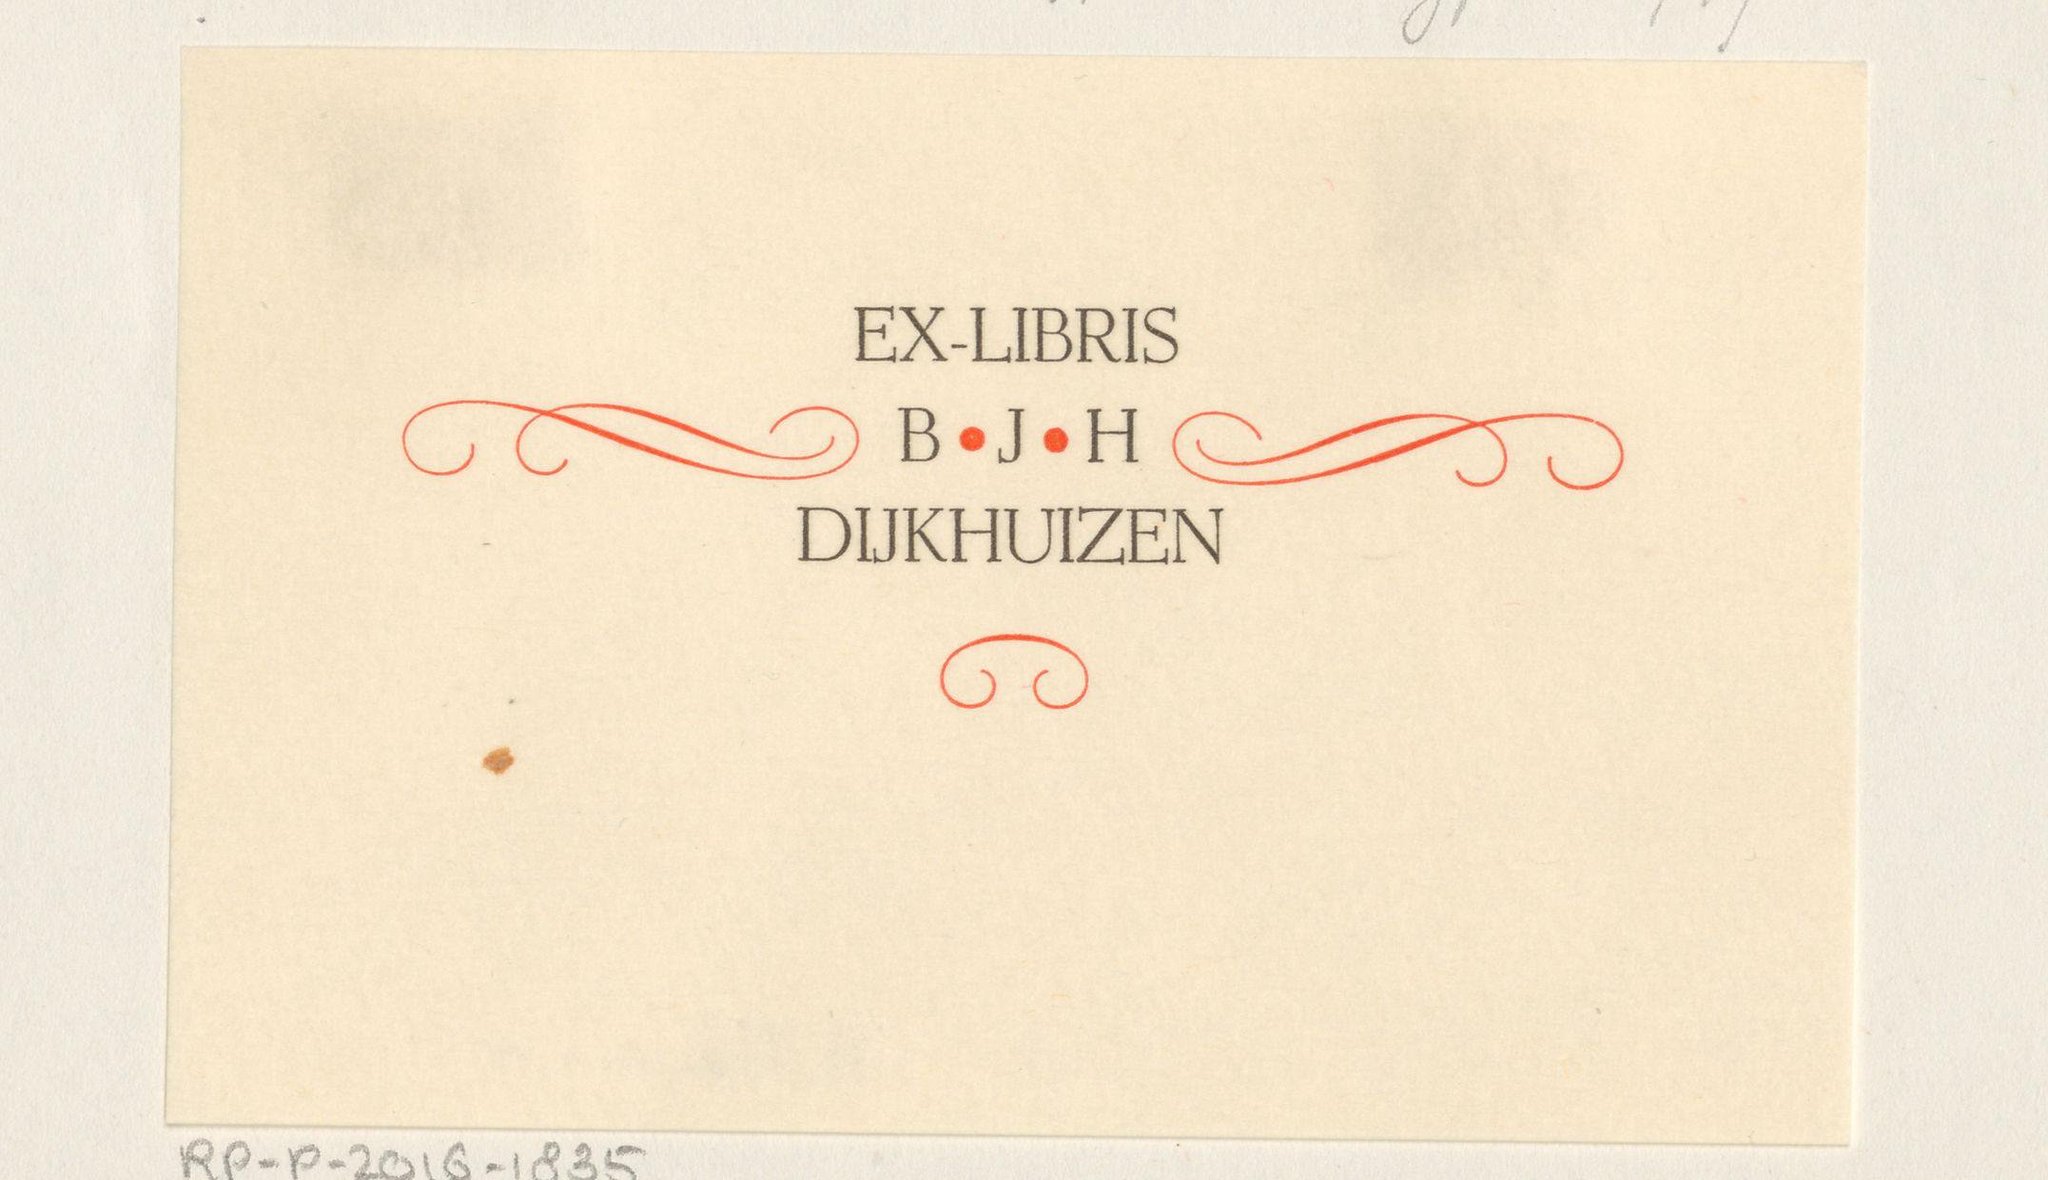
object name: bookplate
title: Ex libris van B.J.H. Dijkhuizen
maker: b. timmer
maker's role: print maker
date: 1940-1960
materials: paper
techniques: printing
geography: netherlands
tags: b.j.h. dijkhuizen